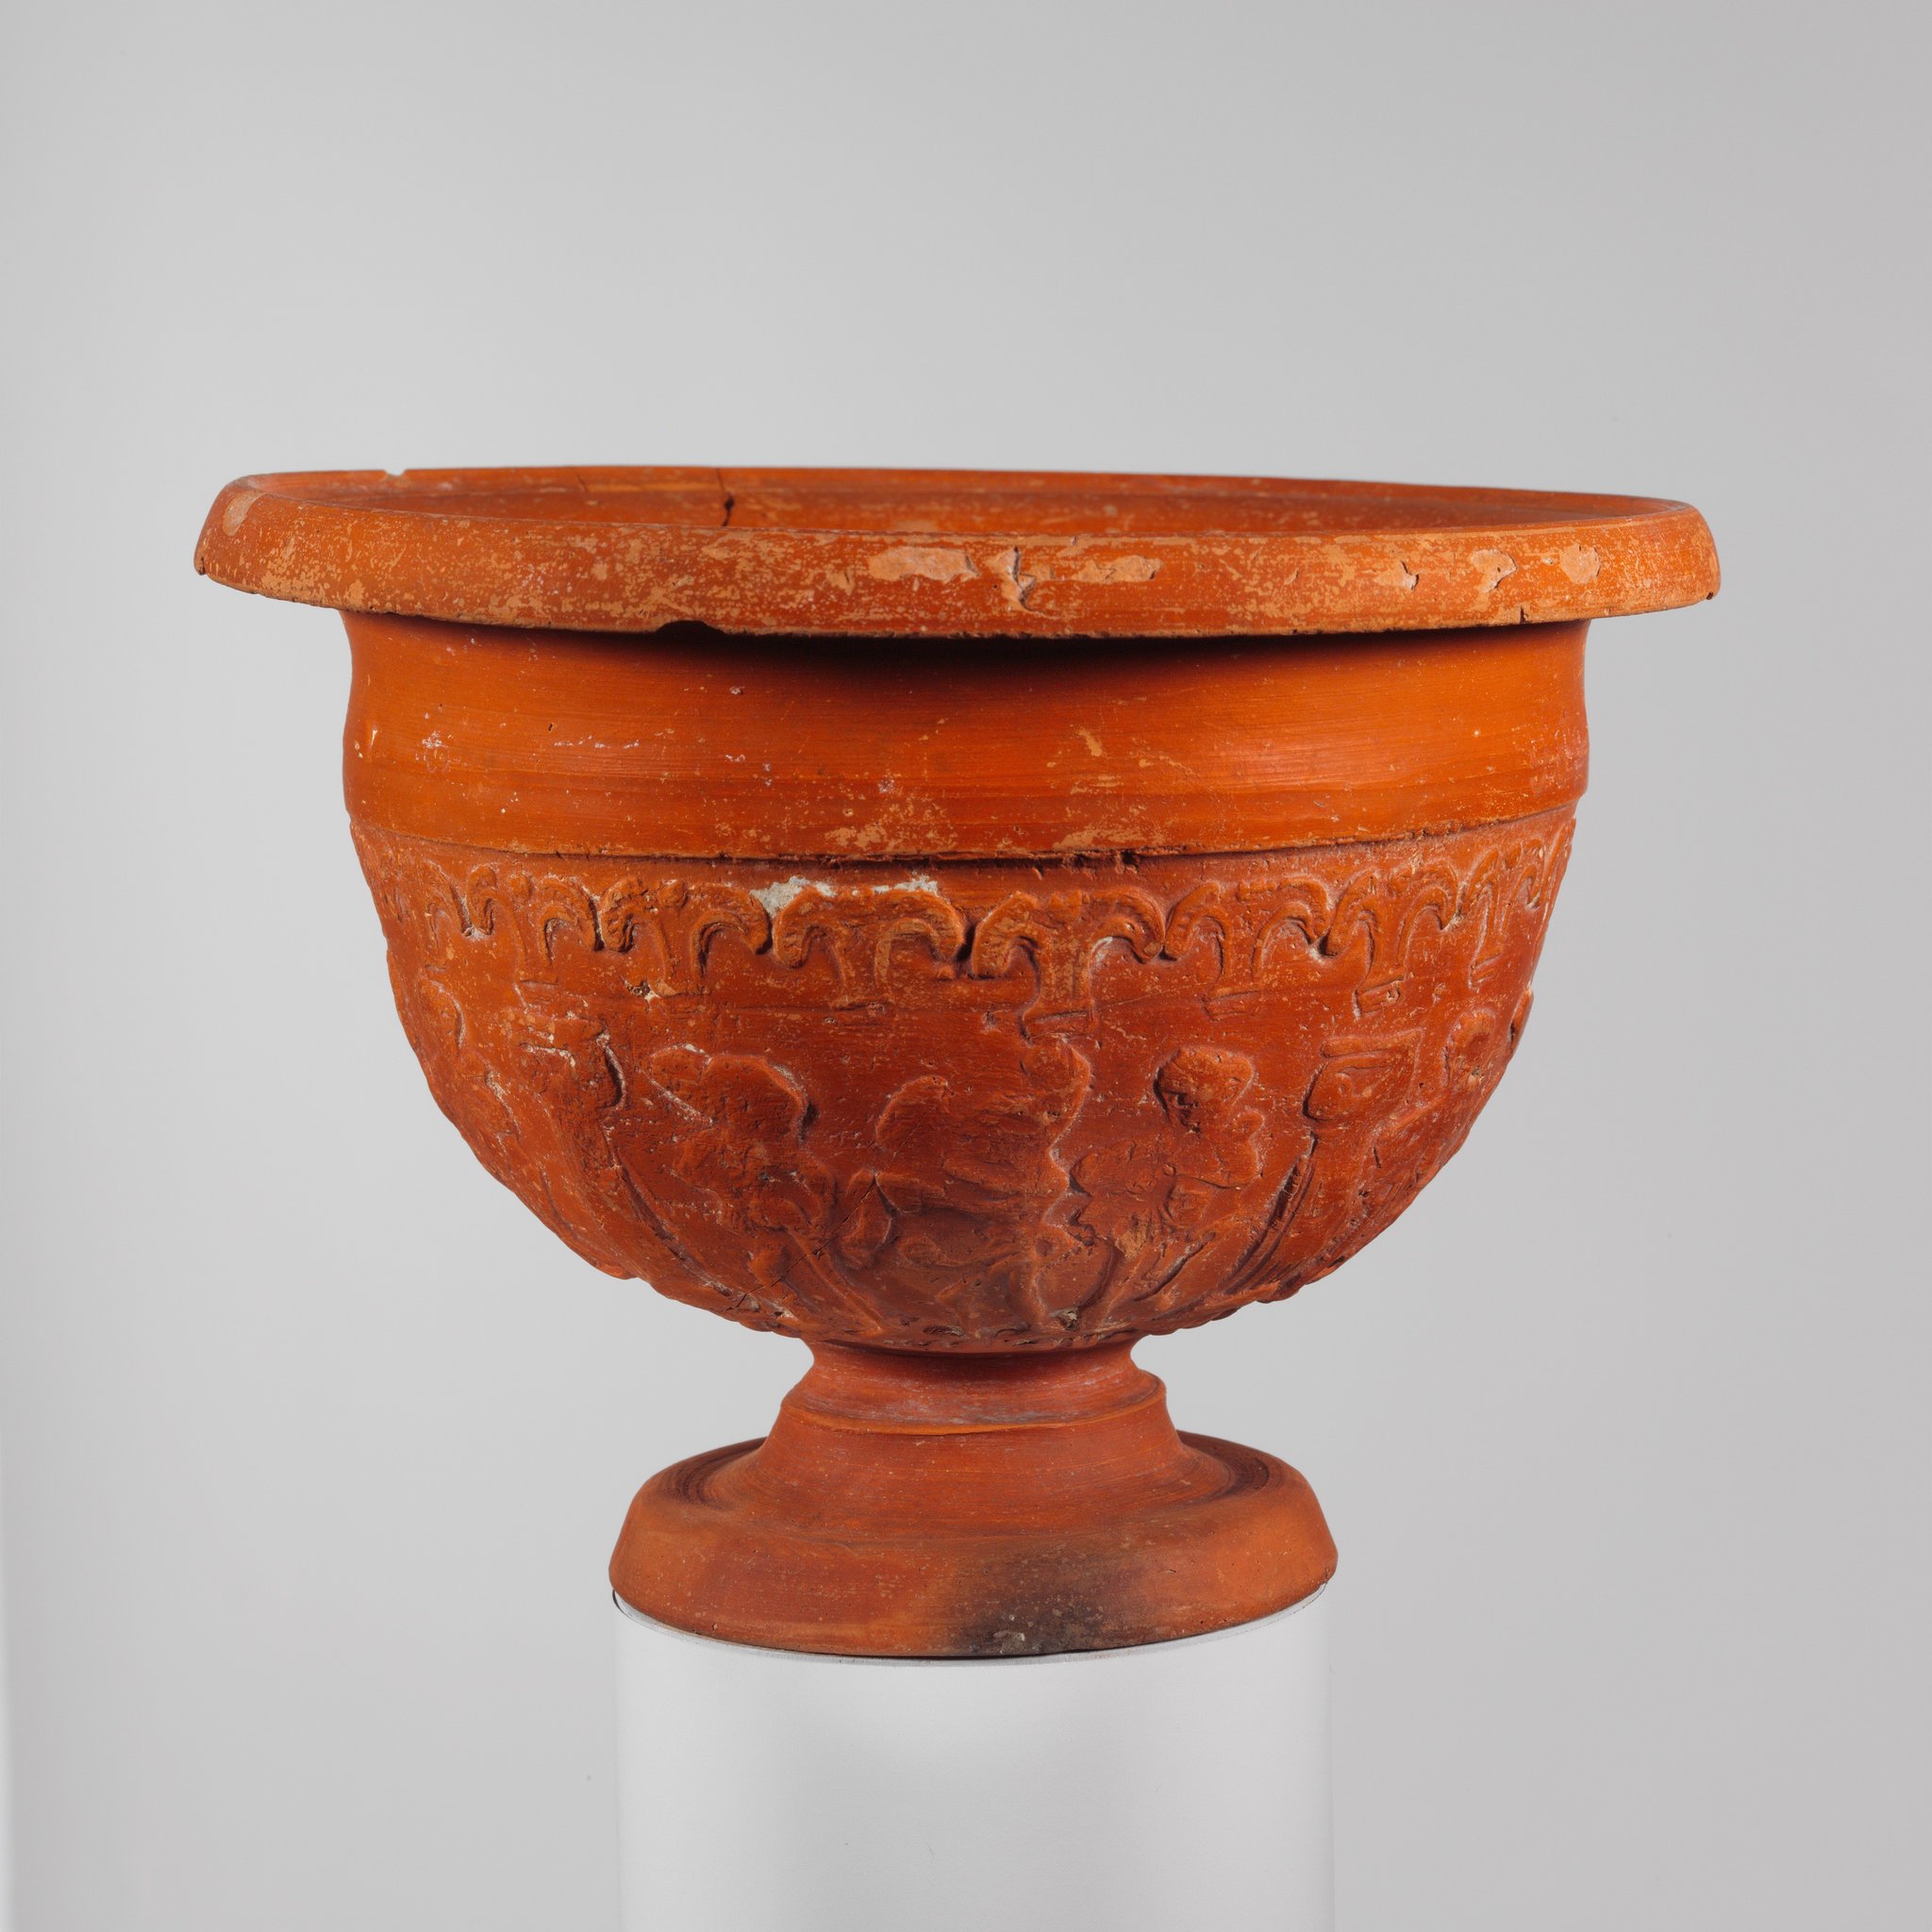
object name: bowl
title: Terracotta bowl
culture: roman, cypriot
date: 1-33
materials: terracotta